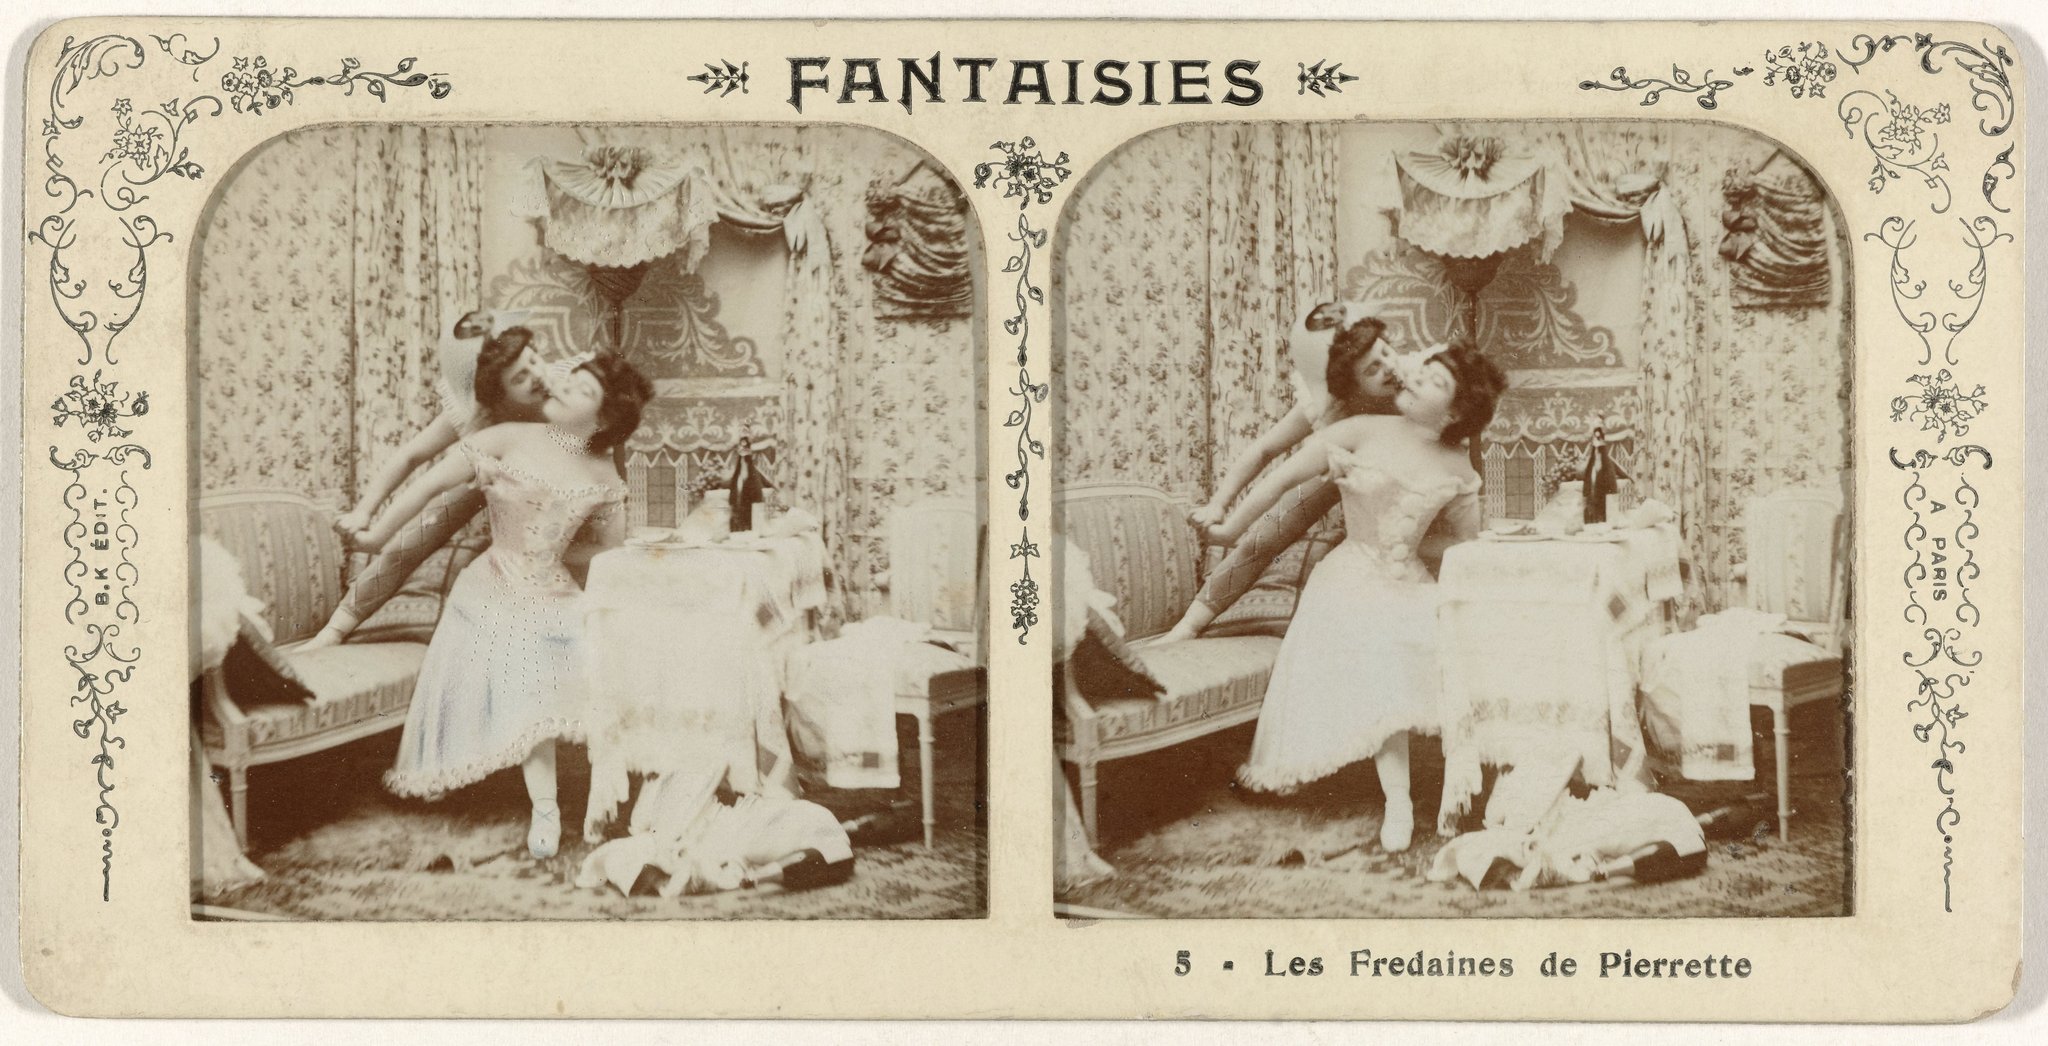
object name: tissue stereograph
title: Les Fredaines de Pierrette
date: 1863-1875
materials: cardboard, paper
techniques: albumen print, hand coloring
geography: france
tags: adult woman (+ two persons), france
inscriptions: number: ‘5’